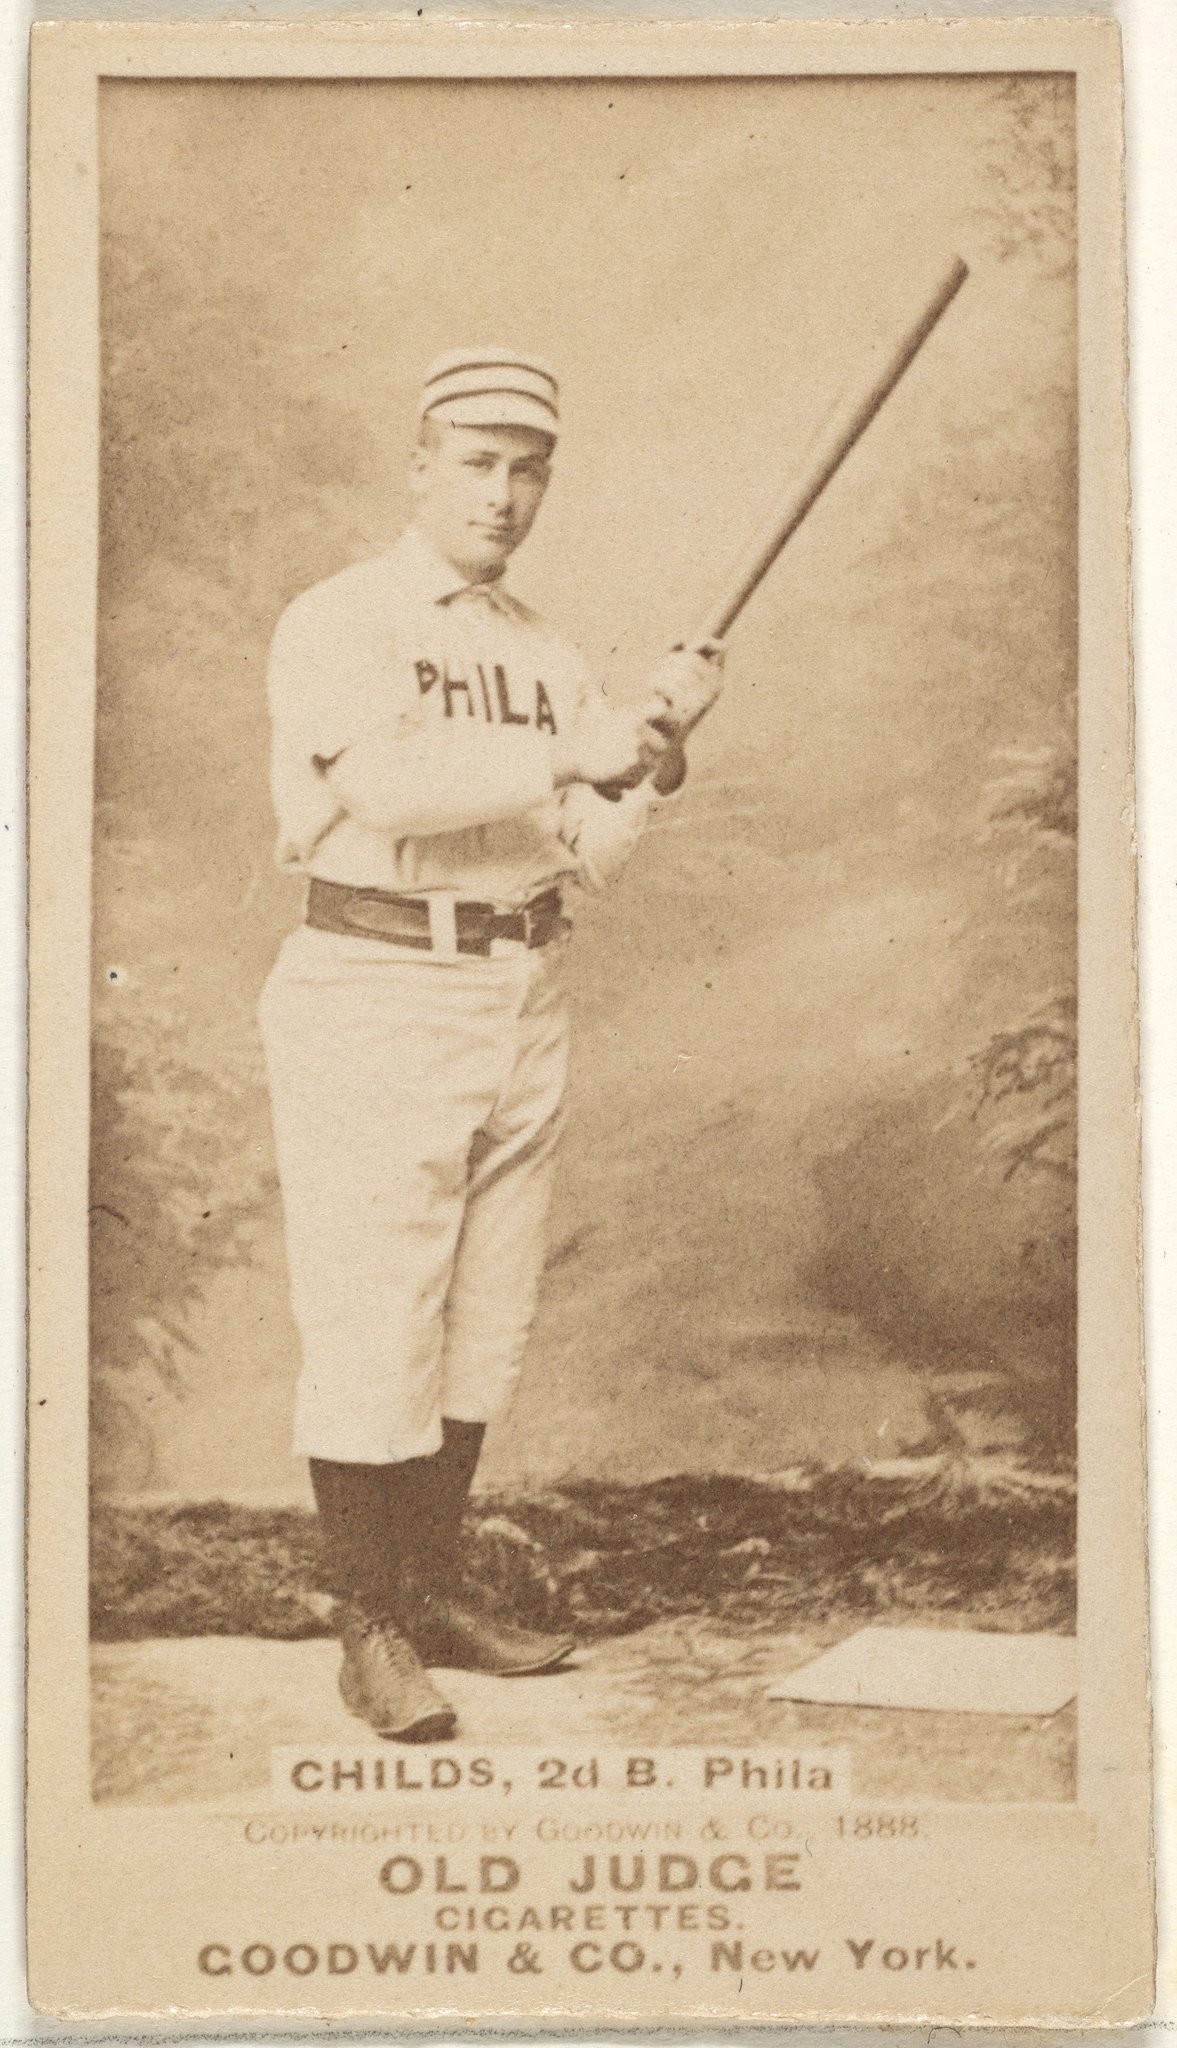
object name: baseball card, photograph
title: Clarence Algernon "Cupid" Childs, 2nd Base, Philadelphia, from the Old Judge series (N172) for Old Judge Cigarettes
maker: goodwin & company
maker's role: publisher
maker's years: 1850-1950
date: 1888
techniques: albumen silver print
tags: men,portraits,baseball,athletes